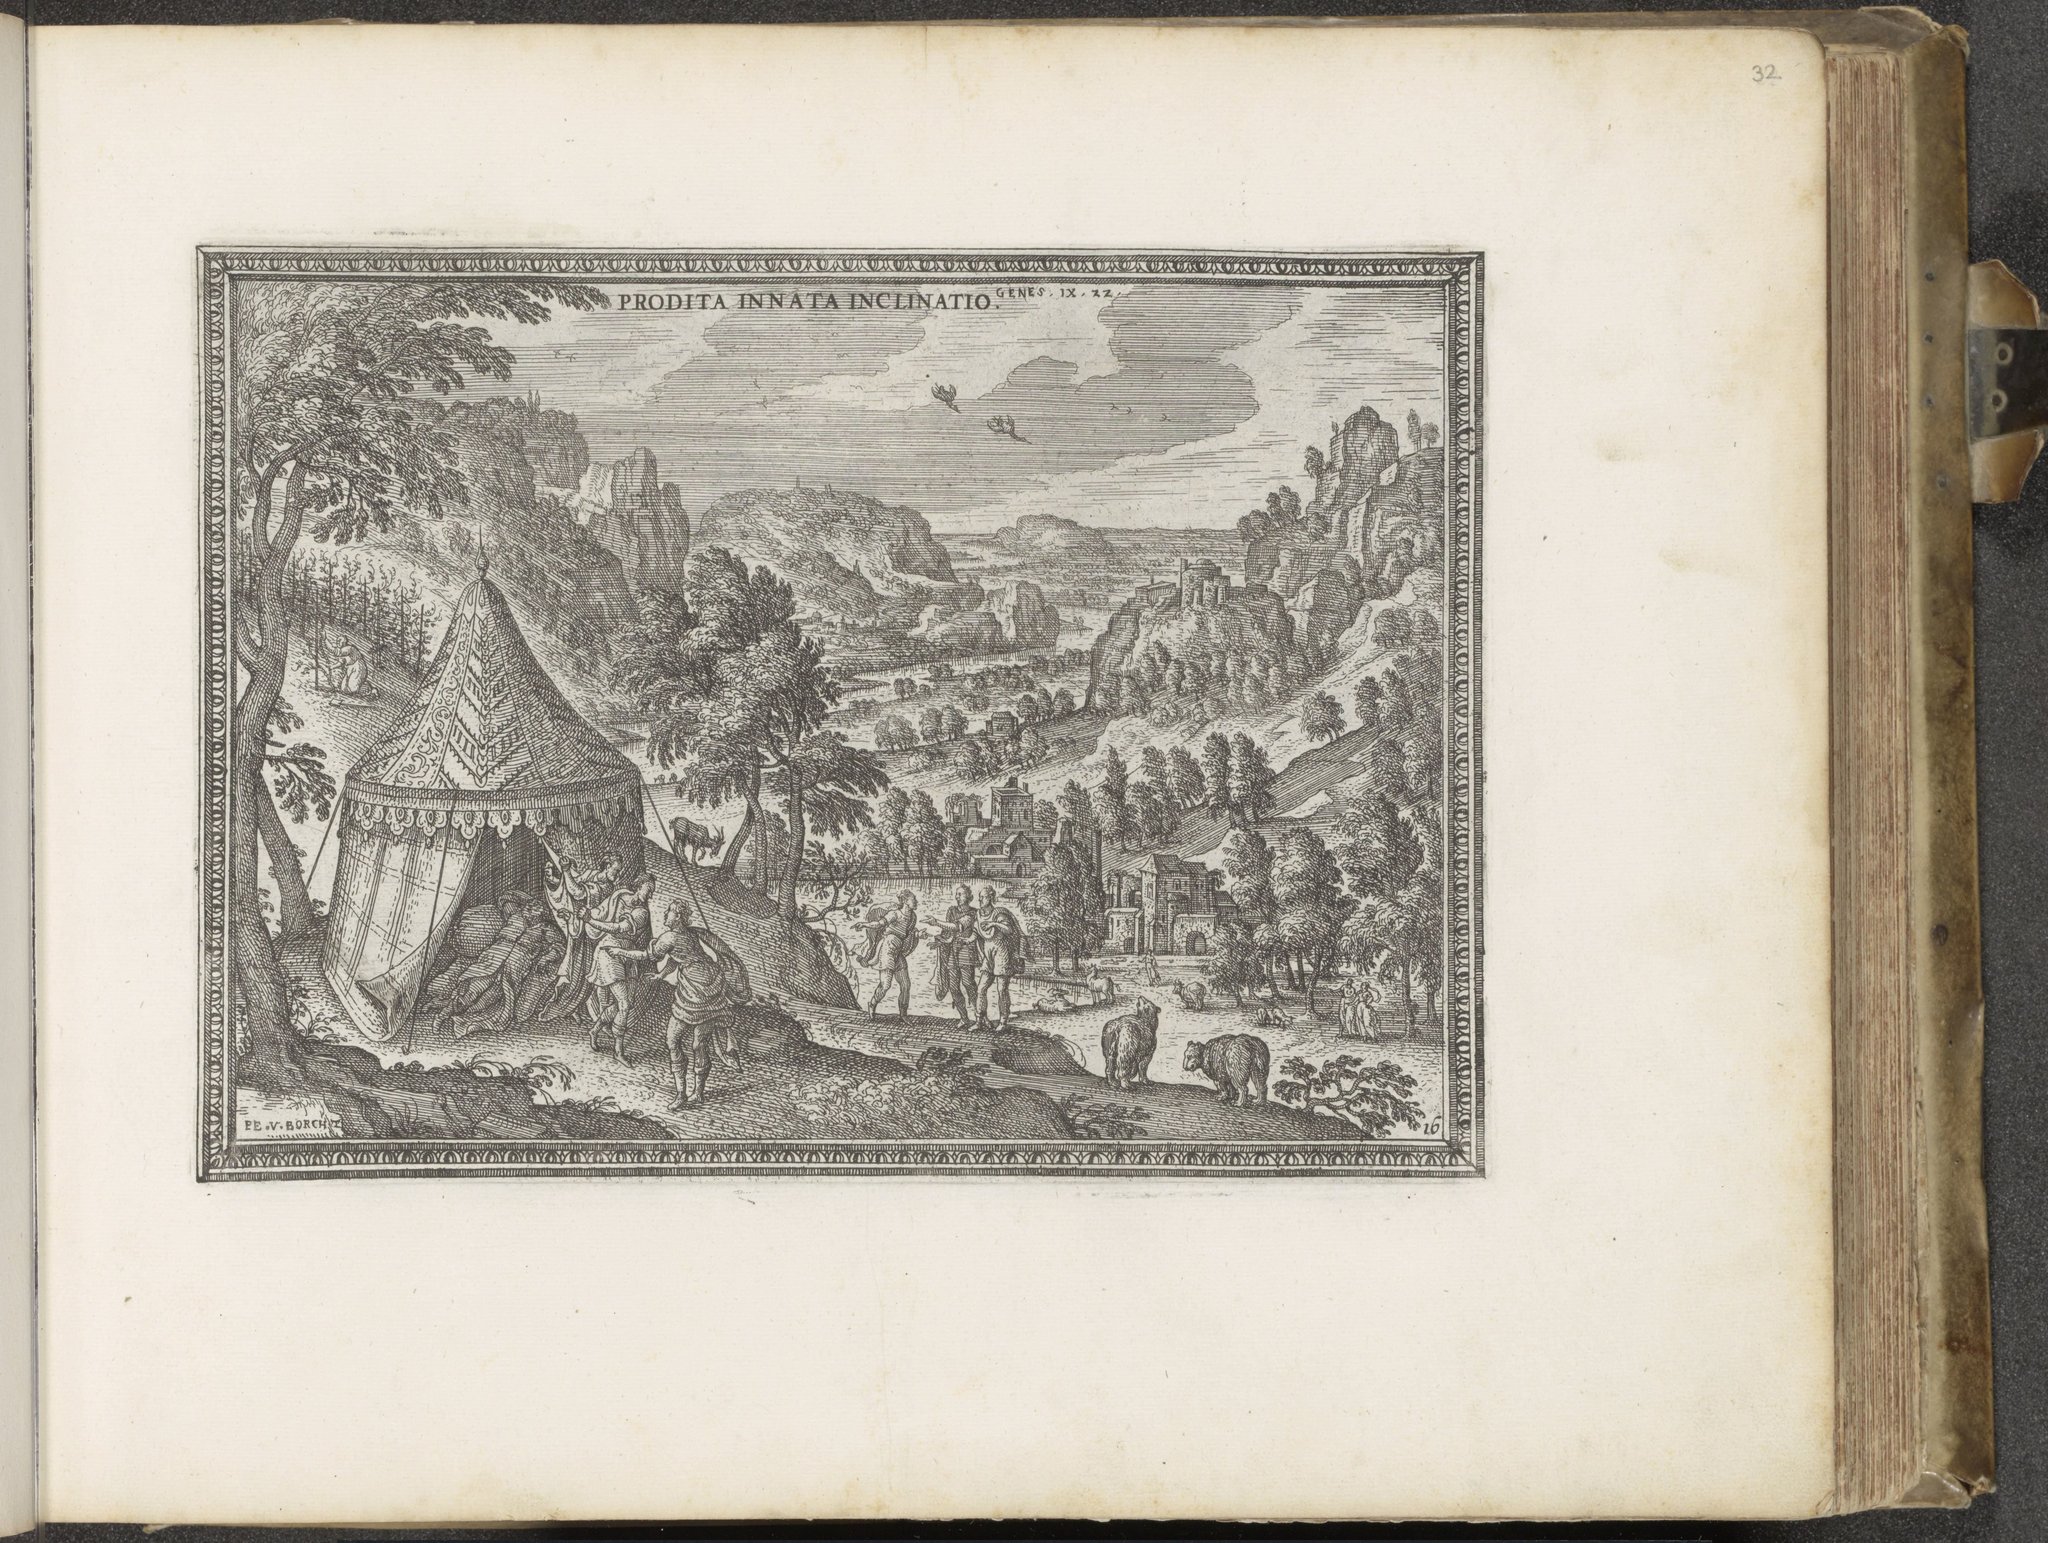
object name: album leaf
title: Prodita innata inclinatio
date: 1582-1593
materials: paper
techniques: etching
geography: amsterdam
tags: shem and japheth cover their father noah; ham usually stands nearby deriding him, the drunkenness of noah, old testament, the mocking of noah: ham finds his father (partially) naked sleeping out of doors (or in his tent, or in the vineyard cottage); ham calls his brothers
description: In een heuvellandschap vertelt Cham aan zijn broers dat zijn vader Noach halfnaakt in zijn tent ligt. Rechts de tent met Noach. Cham wijst naar hem en bespot hem. Sem en Jafet lopen achteruit met een mantel om hun vader daarmee te bedekken (Gen. 9:22). De prent maakt deel uit van een album.